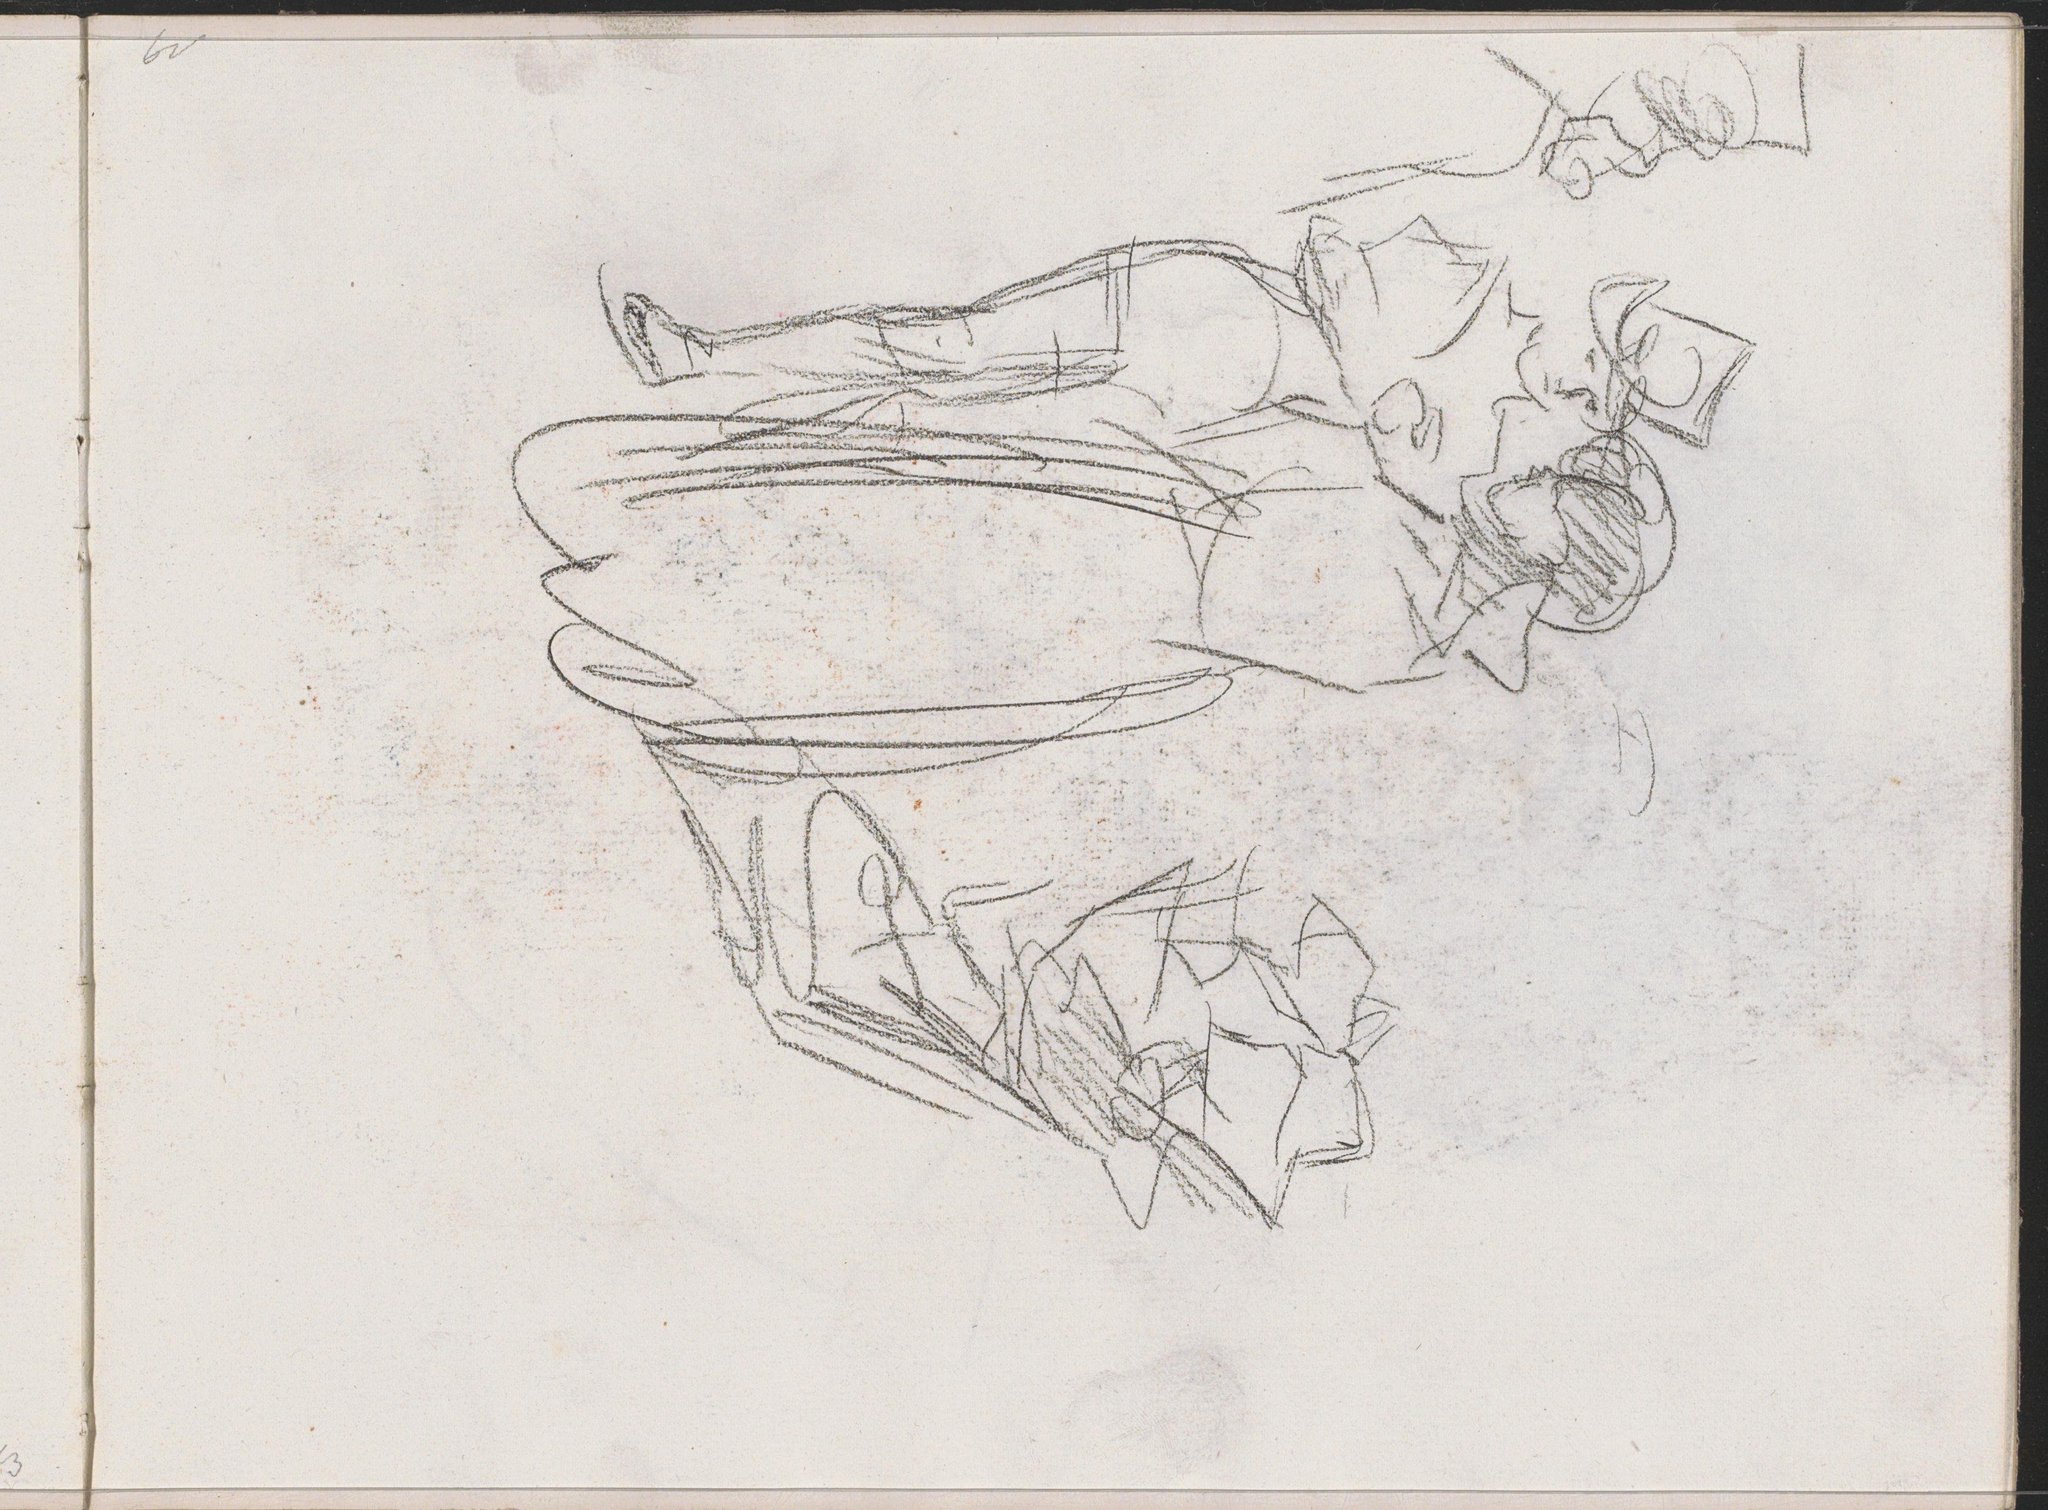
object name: sketchbook leaf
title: Staande figuren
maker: isaac israels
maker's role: draughtsman, painter, print maker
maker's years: 1865-1934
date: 1875-1934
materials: chalk, paper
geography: the hague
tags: adult woman (+ standing), adult man (+ standing)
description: Blad 13 recto uit schetsboek XXII met 30 bladen.